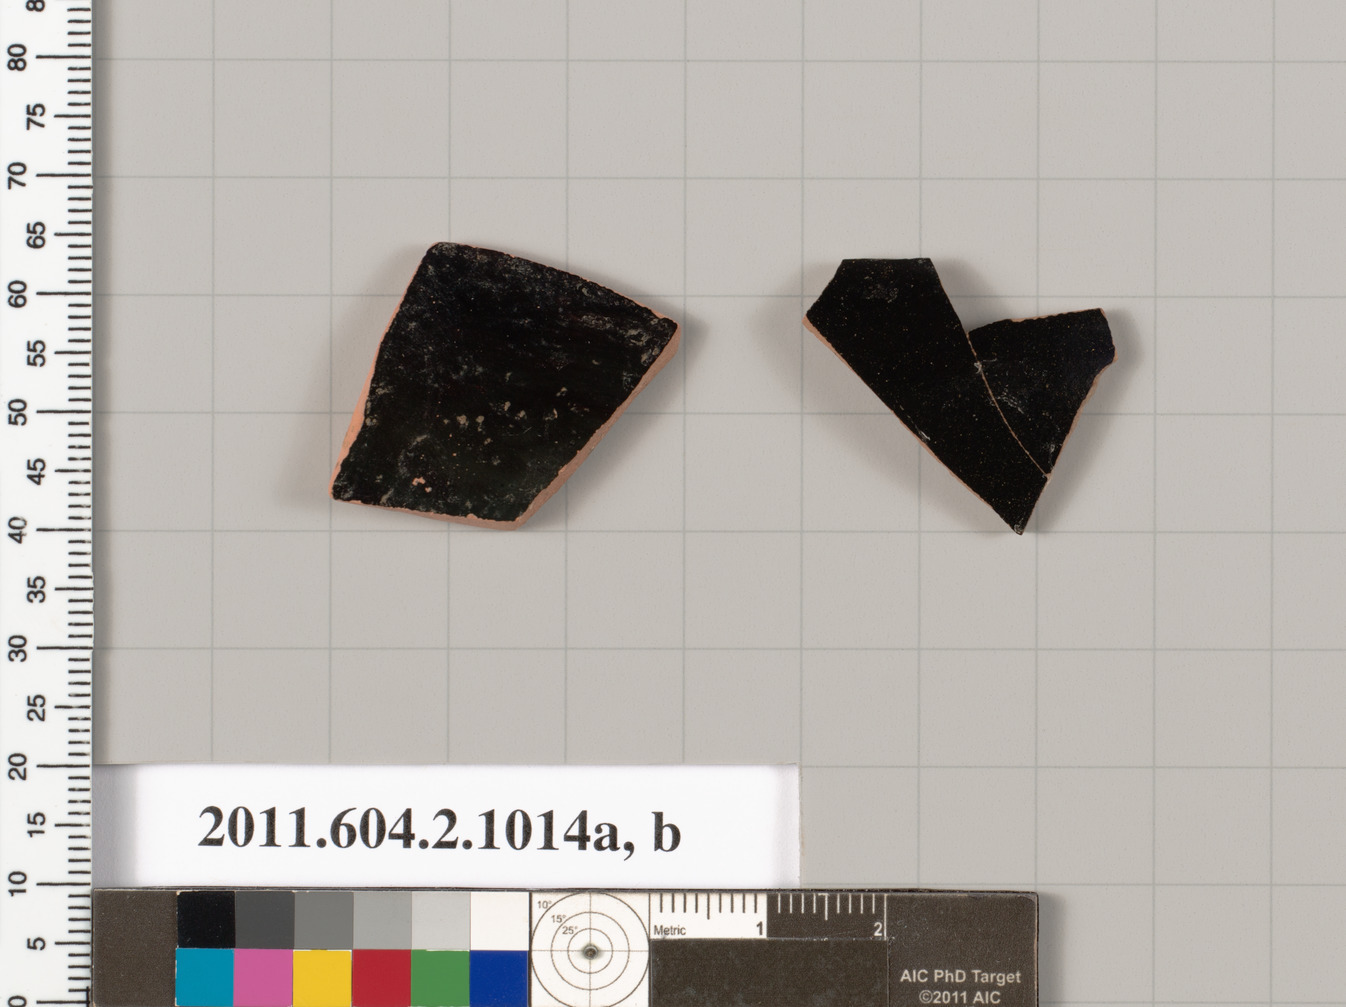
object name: oinochoe fragment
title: Terracotta fragments of oinochoai (jugs)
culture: greek, attic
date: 475-425 BCE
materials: terracotta